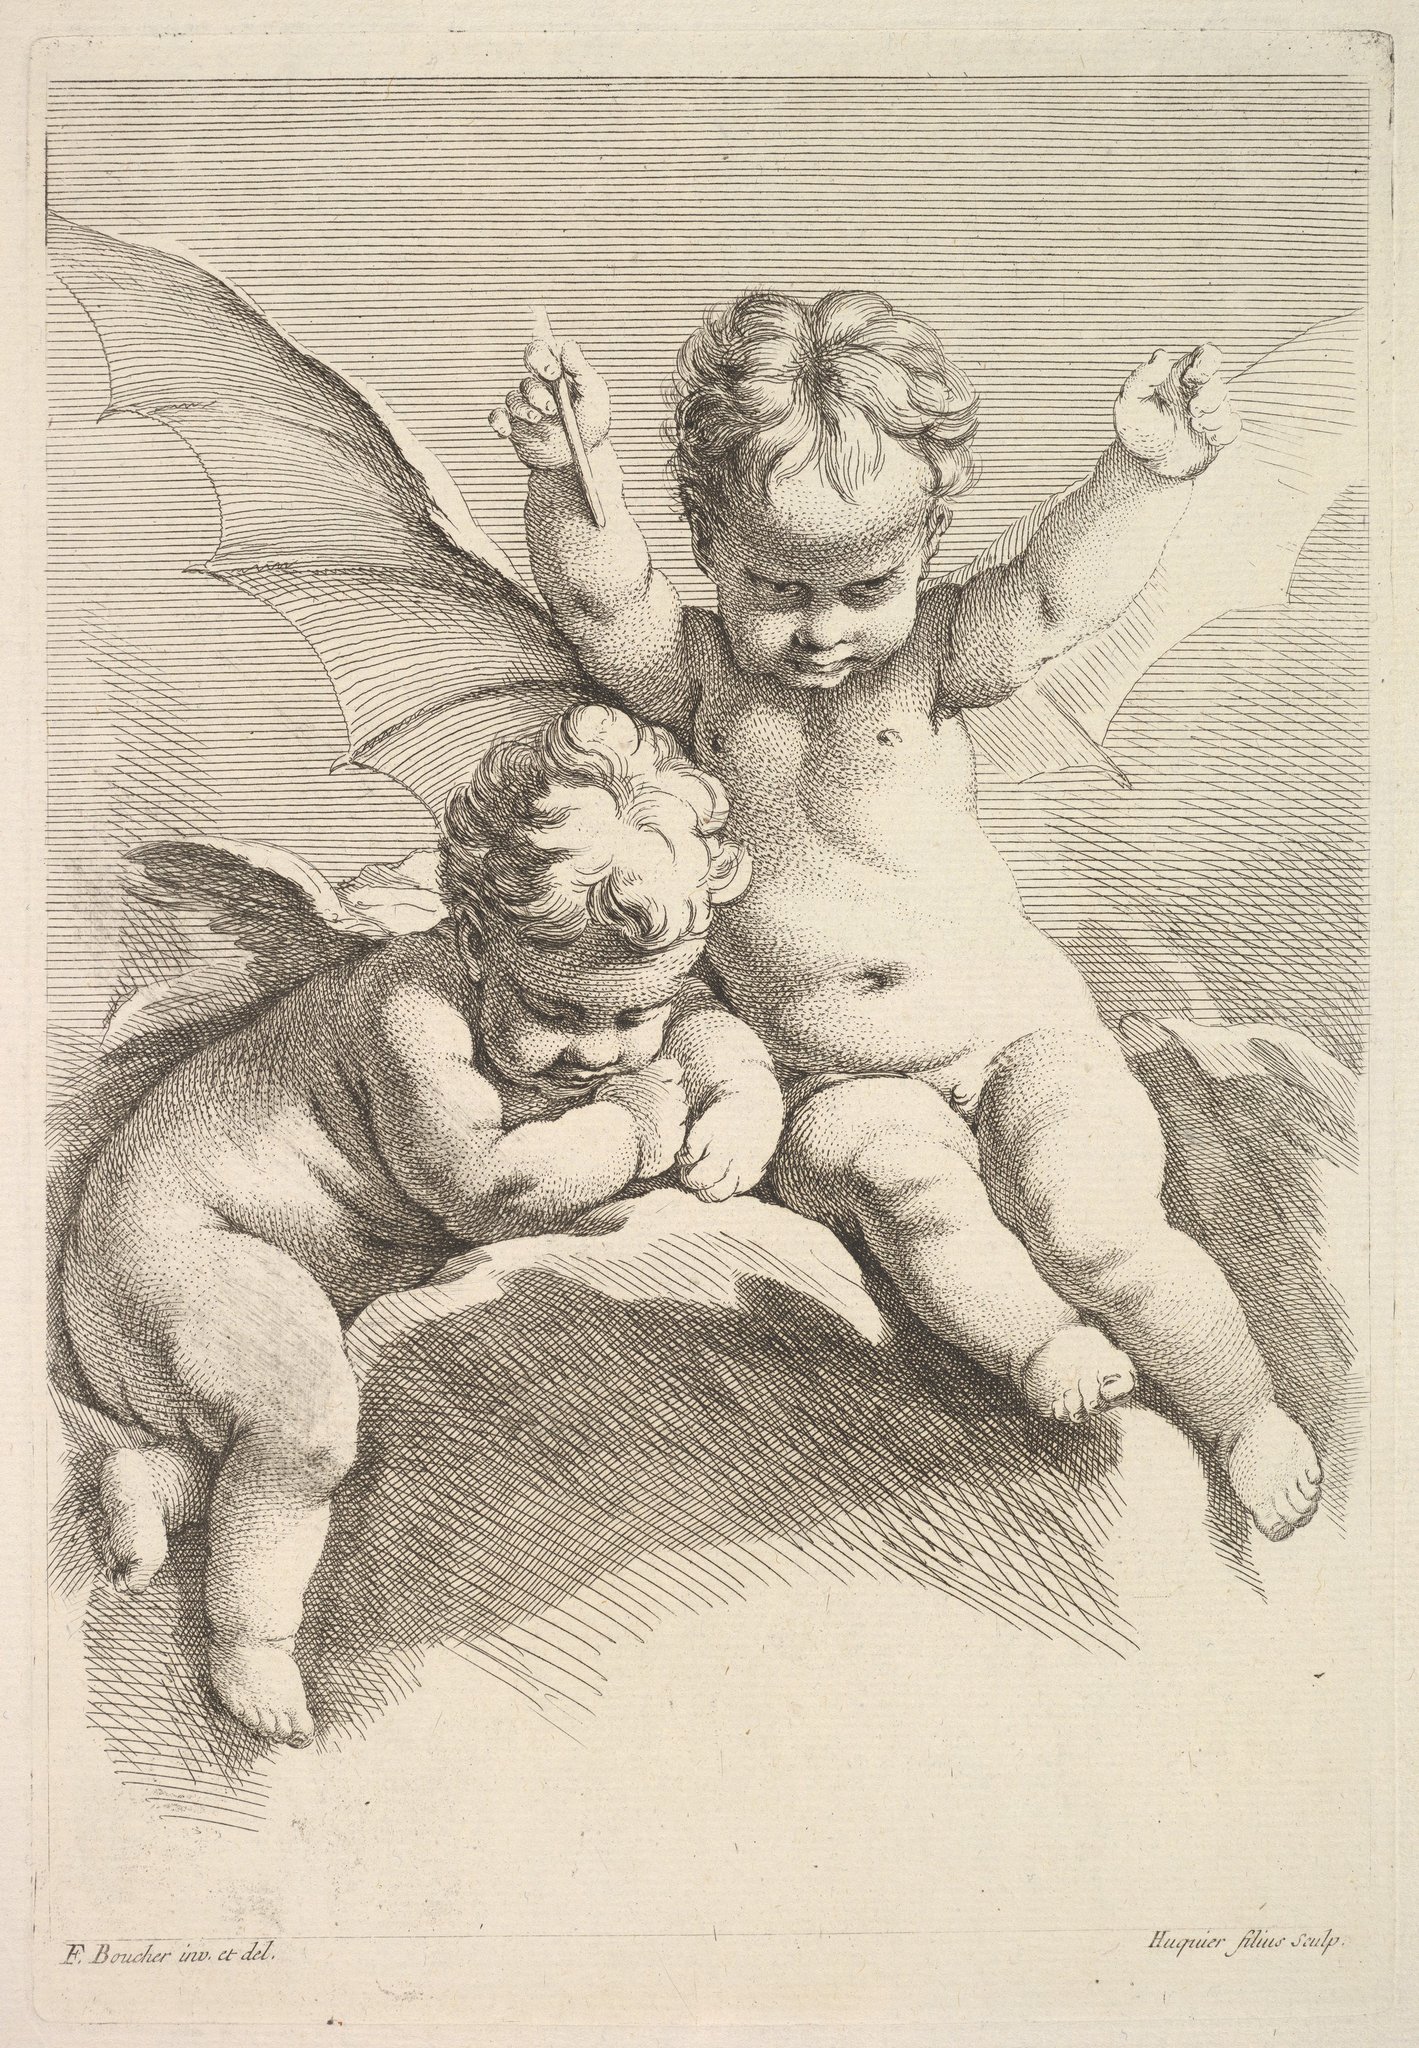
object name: print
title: Two Cupids, One with Bat Wings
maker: jacques gabriel huquier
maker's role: artist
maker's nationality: french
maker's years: 1730-1805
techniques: engraving, etching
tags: cupid